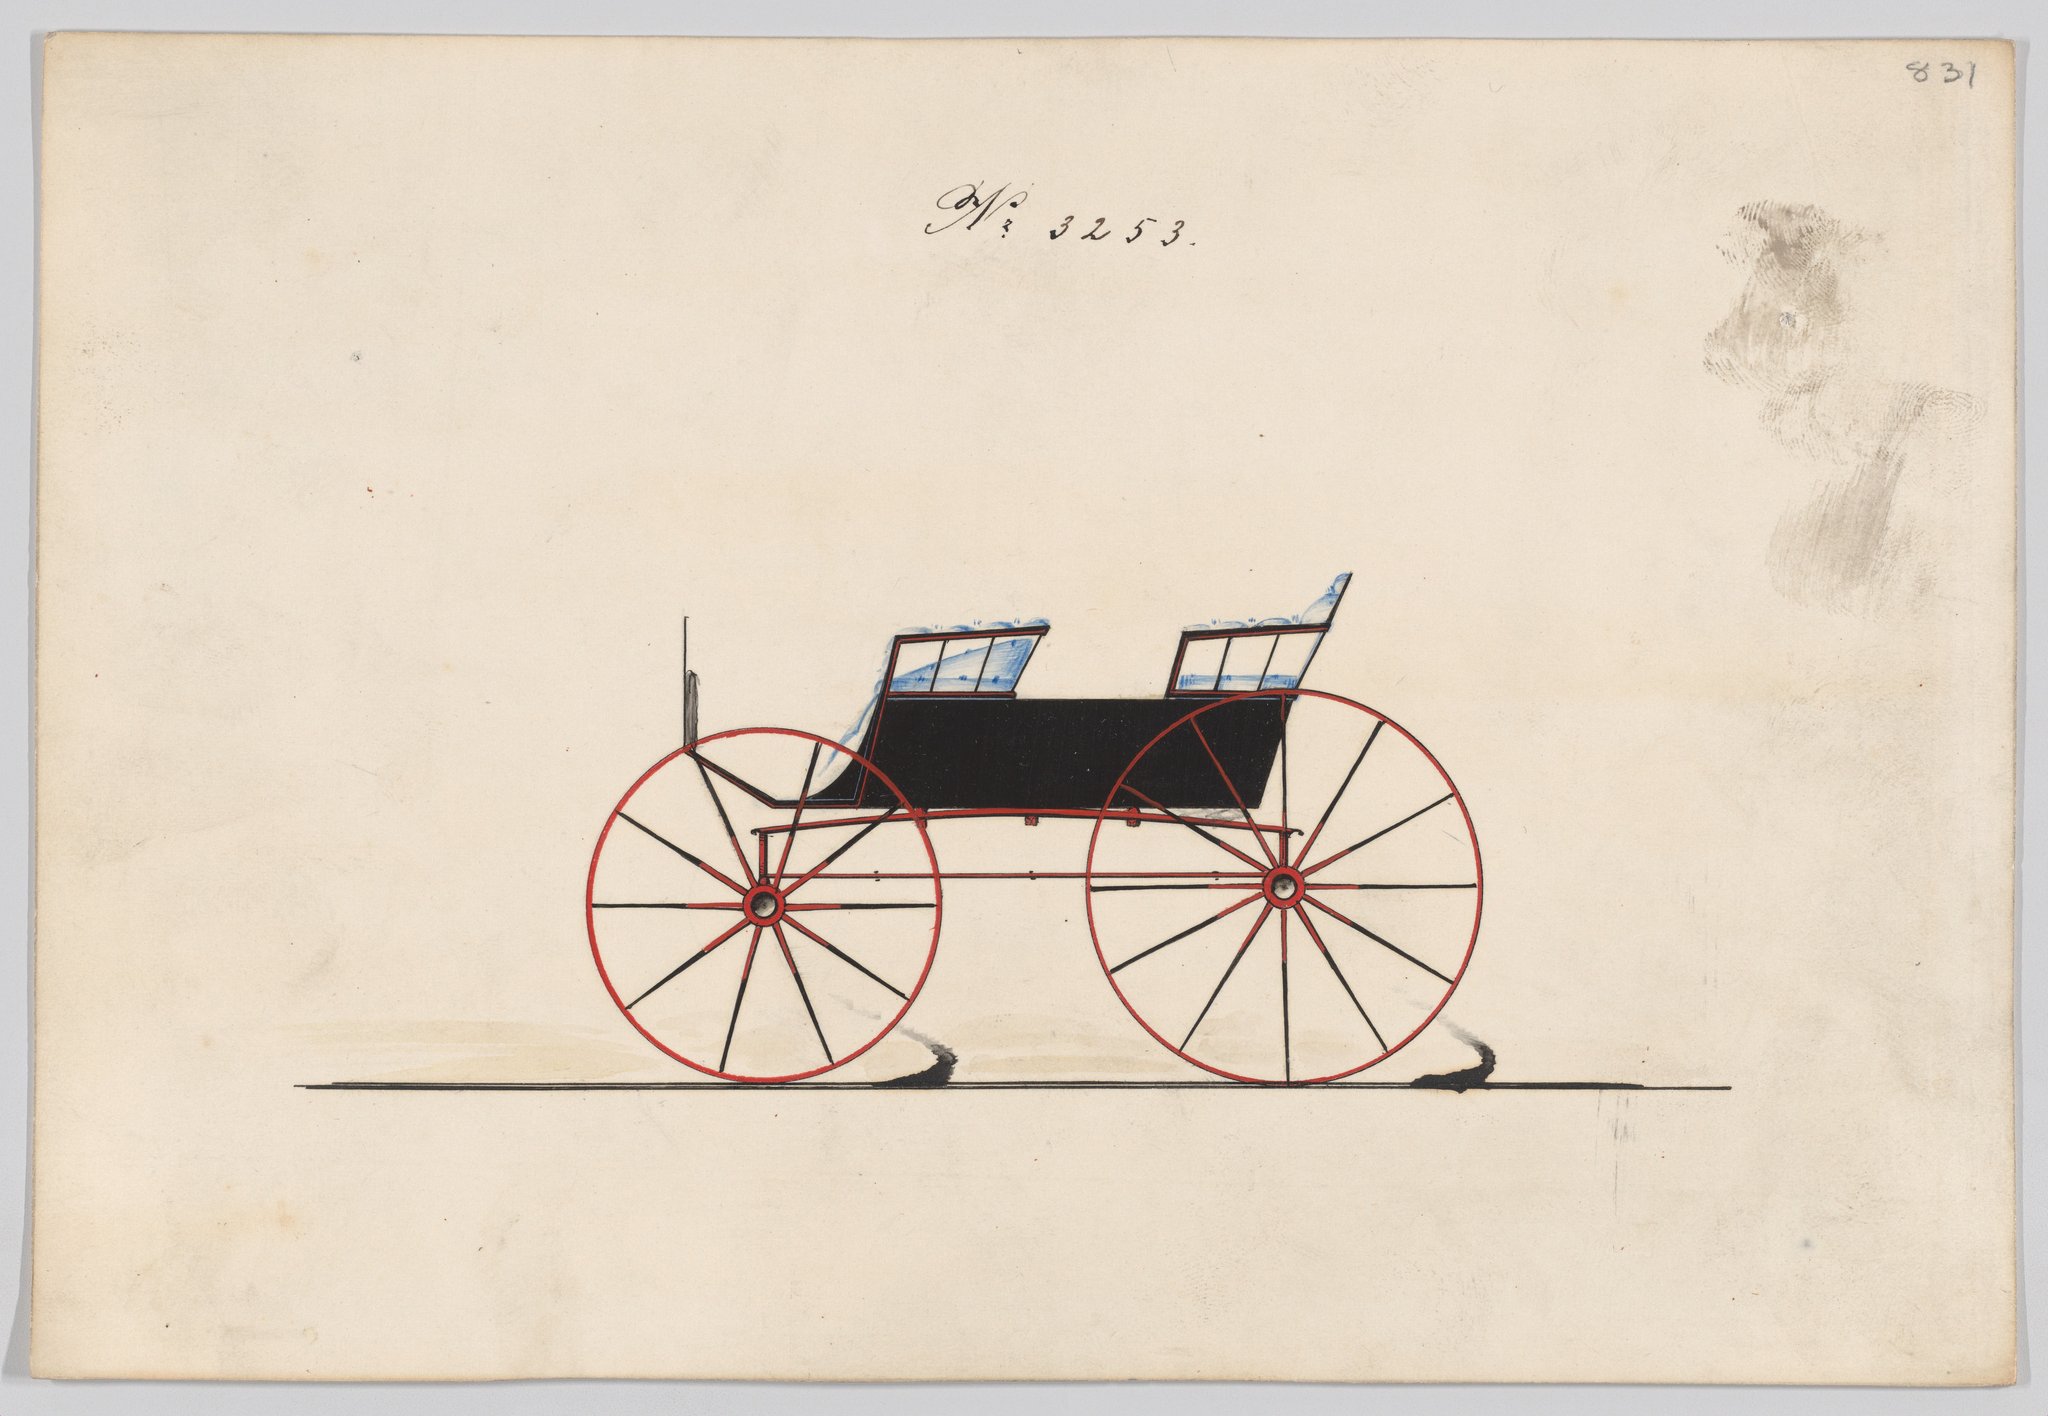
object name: drawing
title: Design for 4 seat Phaeton, no top, no. 3253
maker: brewster & co.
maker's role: manufacturer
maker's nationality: american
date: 1876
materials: gouache, gum arabic, ink, watercolor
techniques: pen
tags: carriages